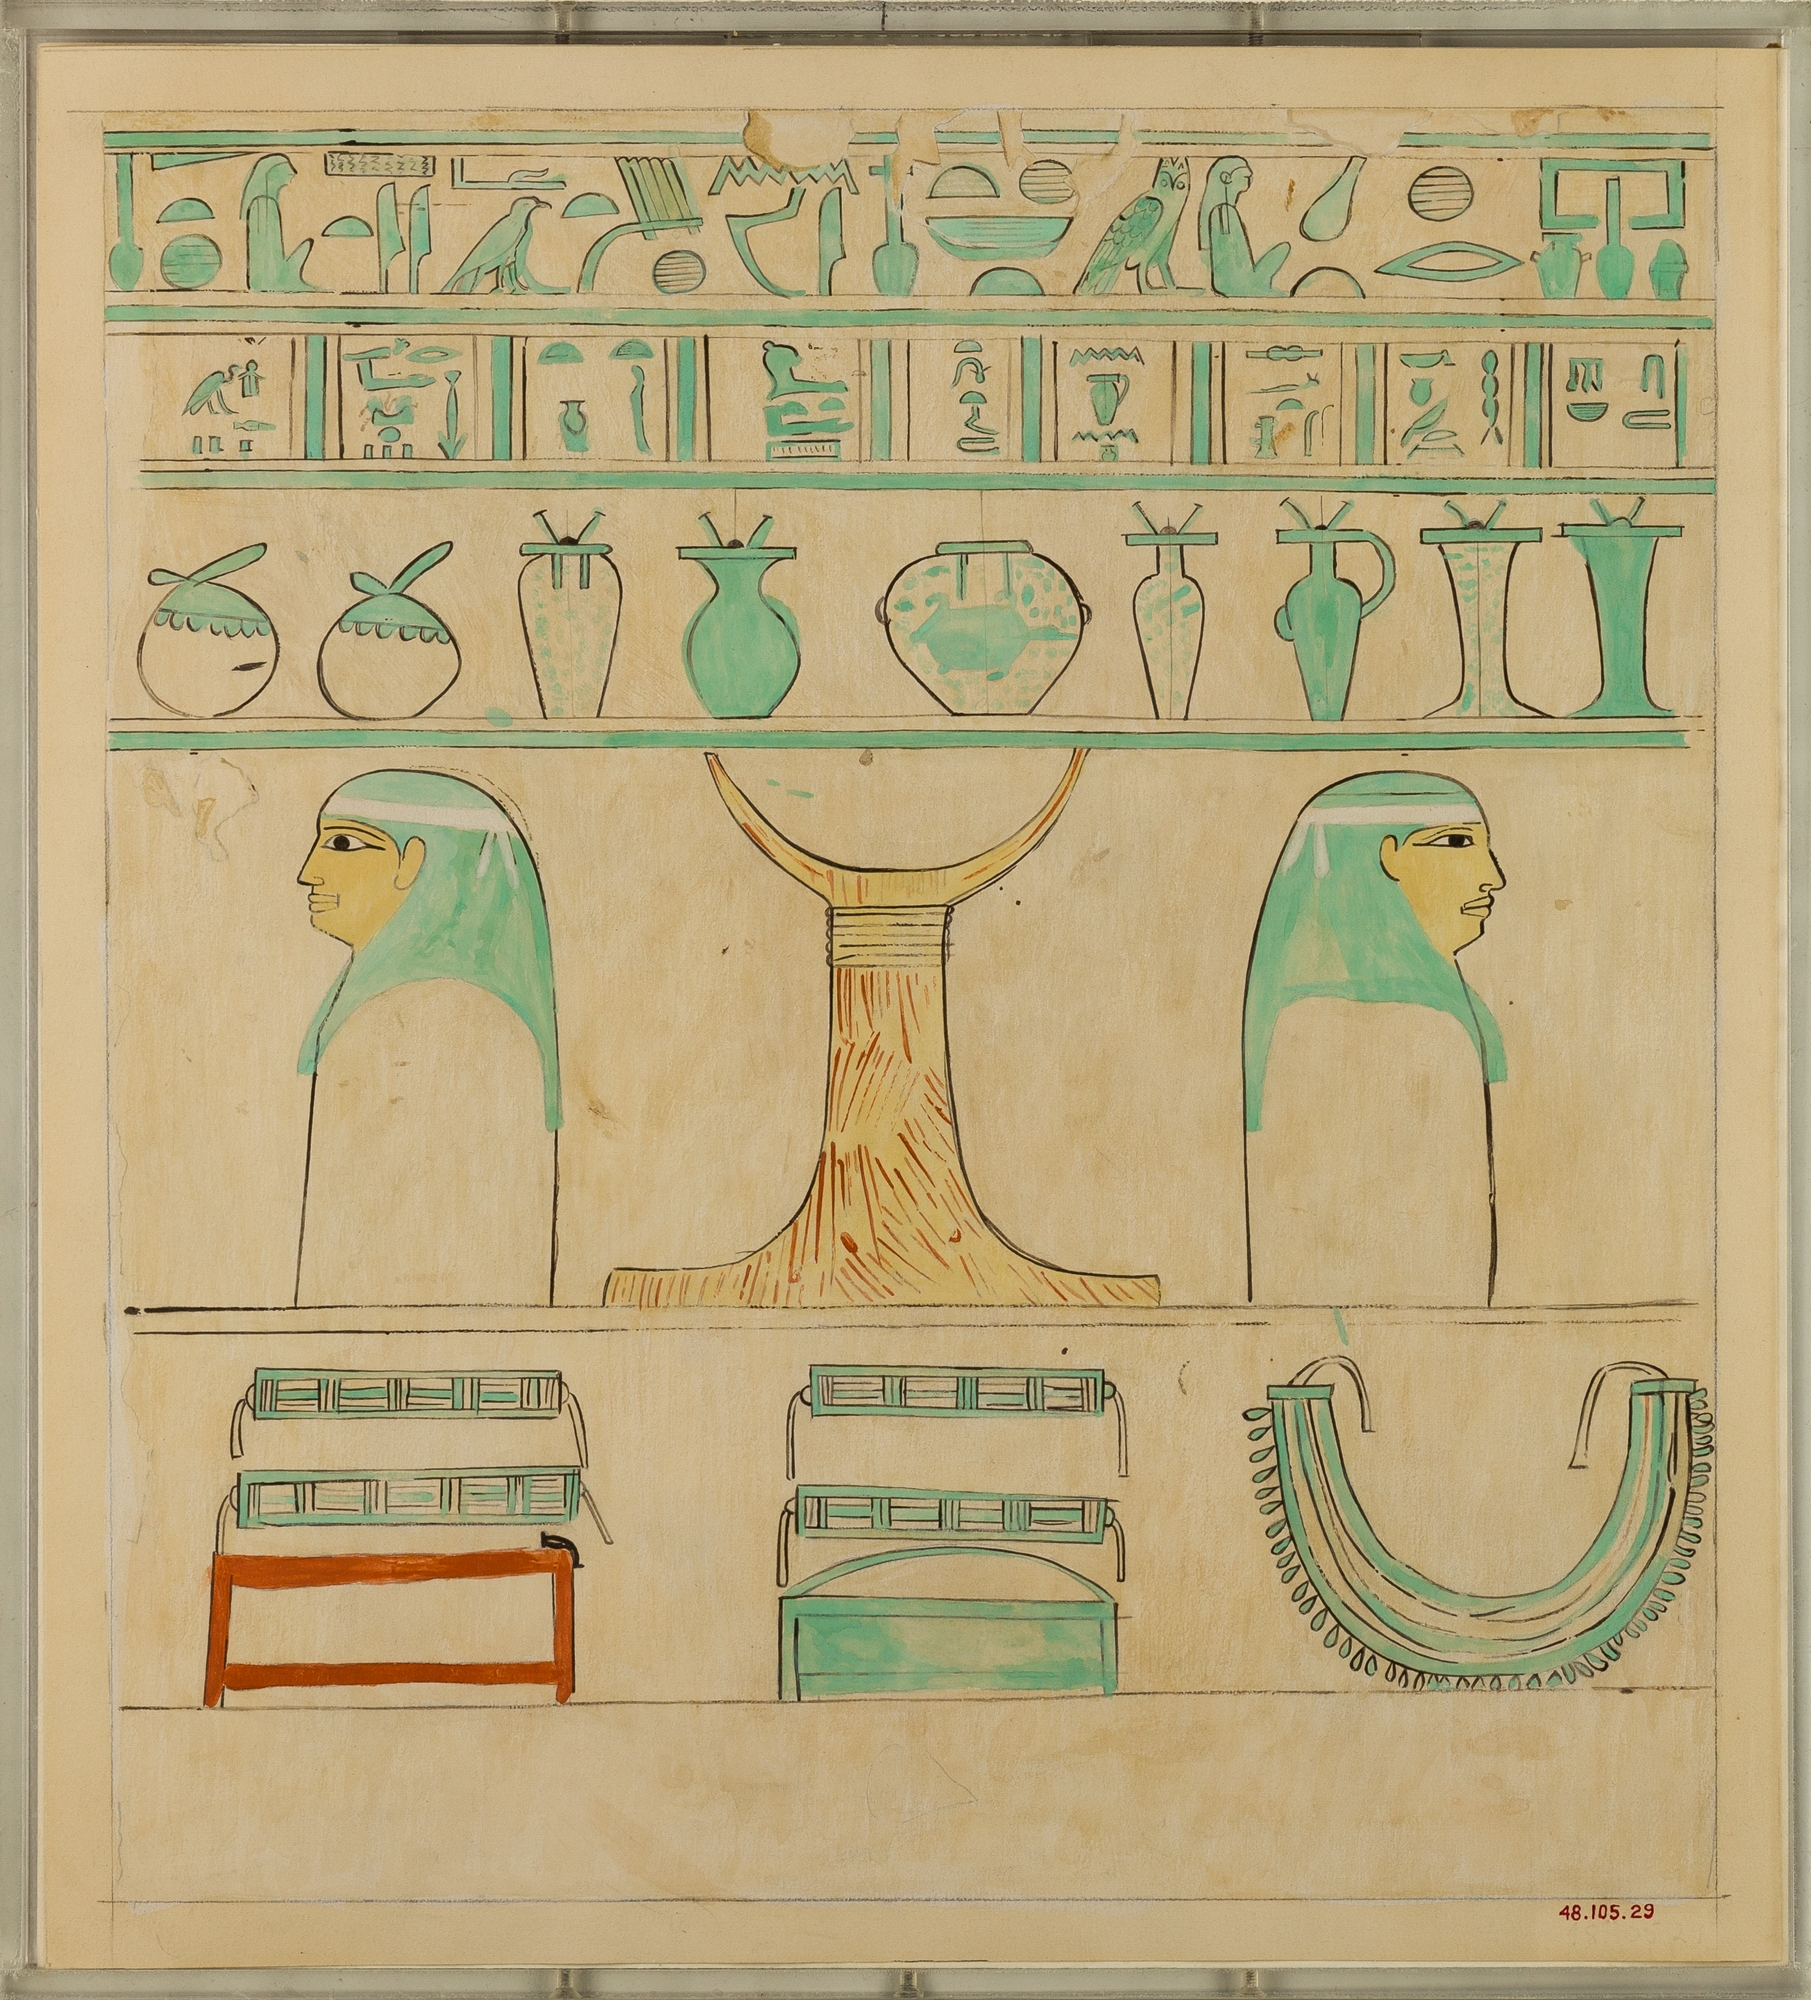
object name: facsimile, aashyt sarcophagus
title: Facsimile of the painting at the head end of the sarcophagus of Aashyt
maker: charles k. wilkinson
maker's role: artist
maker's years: 1897-1986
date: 2051-2030 BCE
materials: paper, paint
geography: egypt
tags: heads,hieroglyphs,sarcophagus